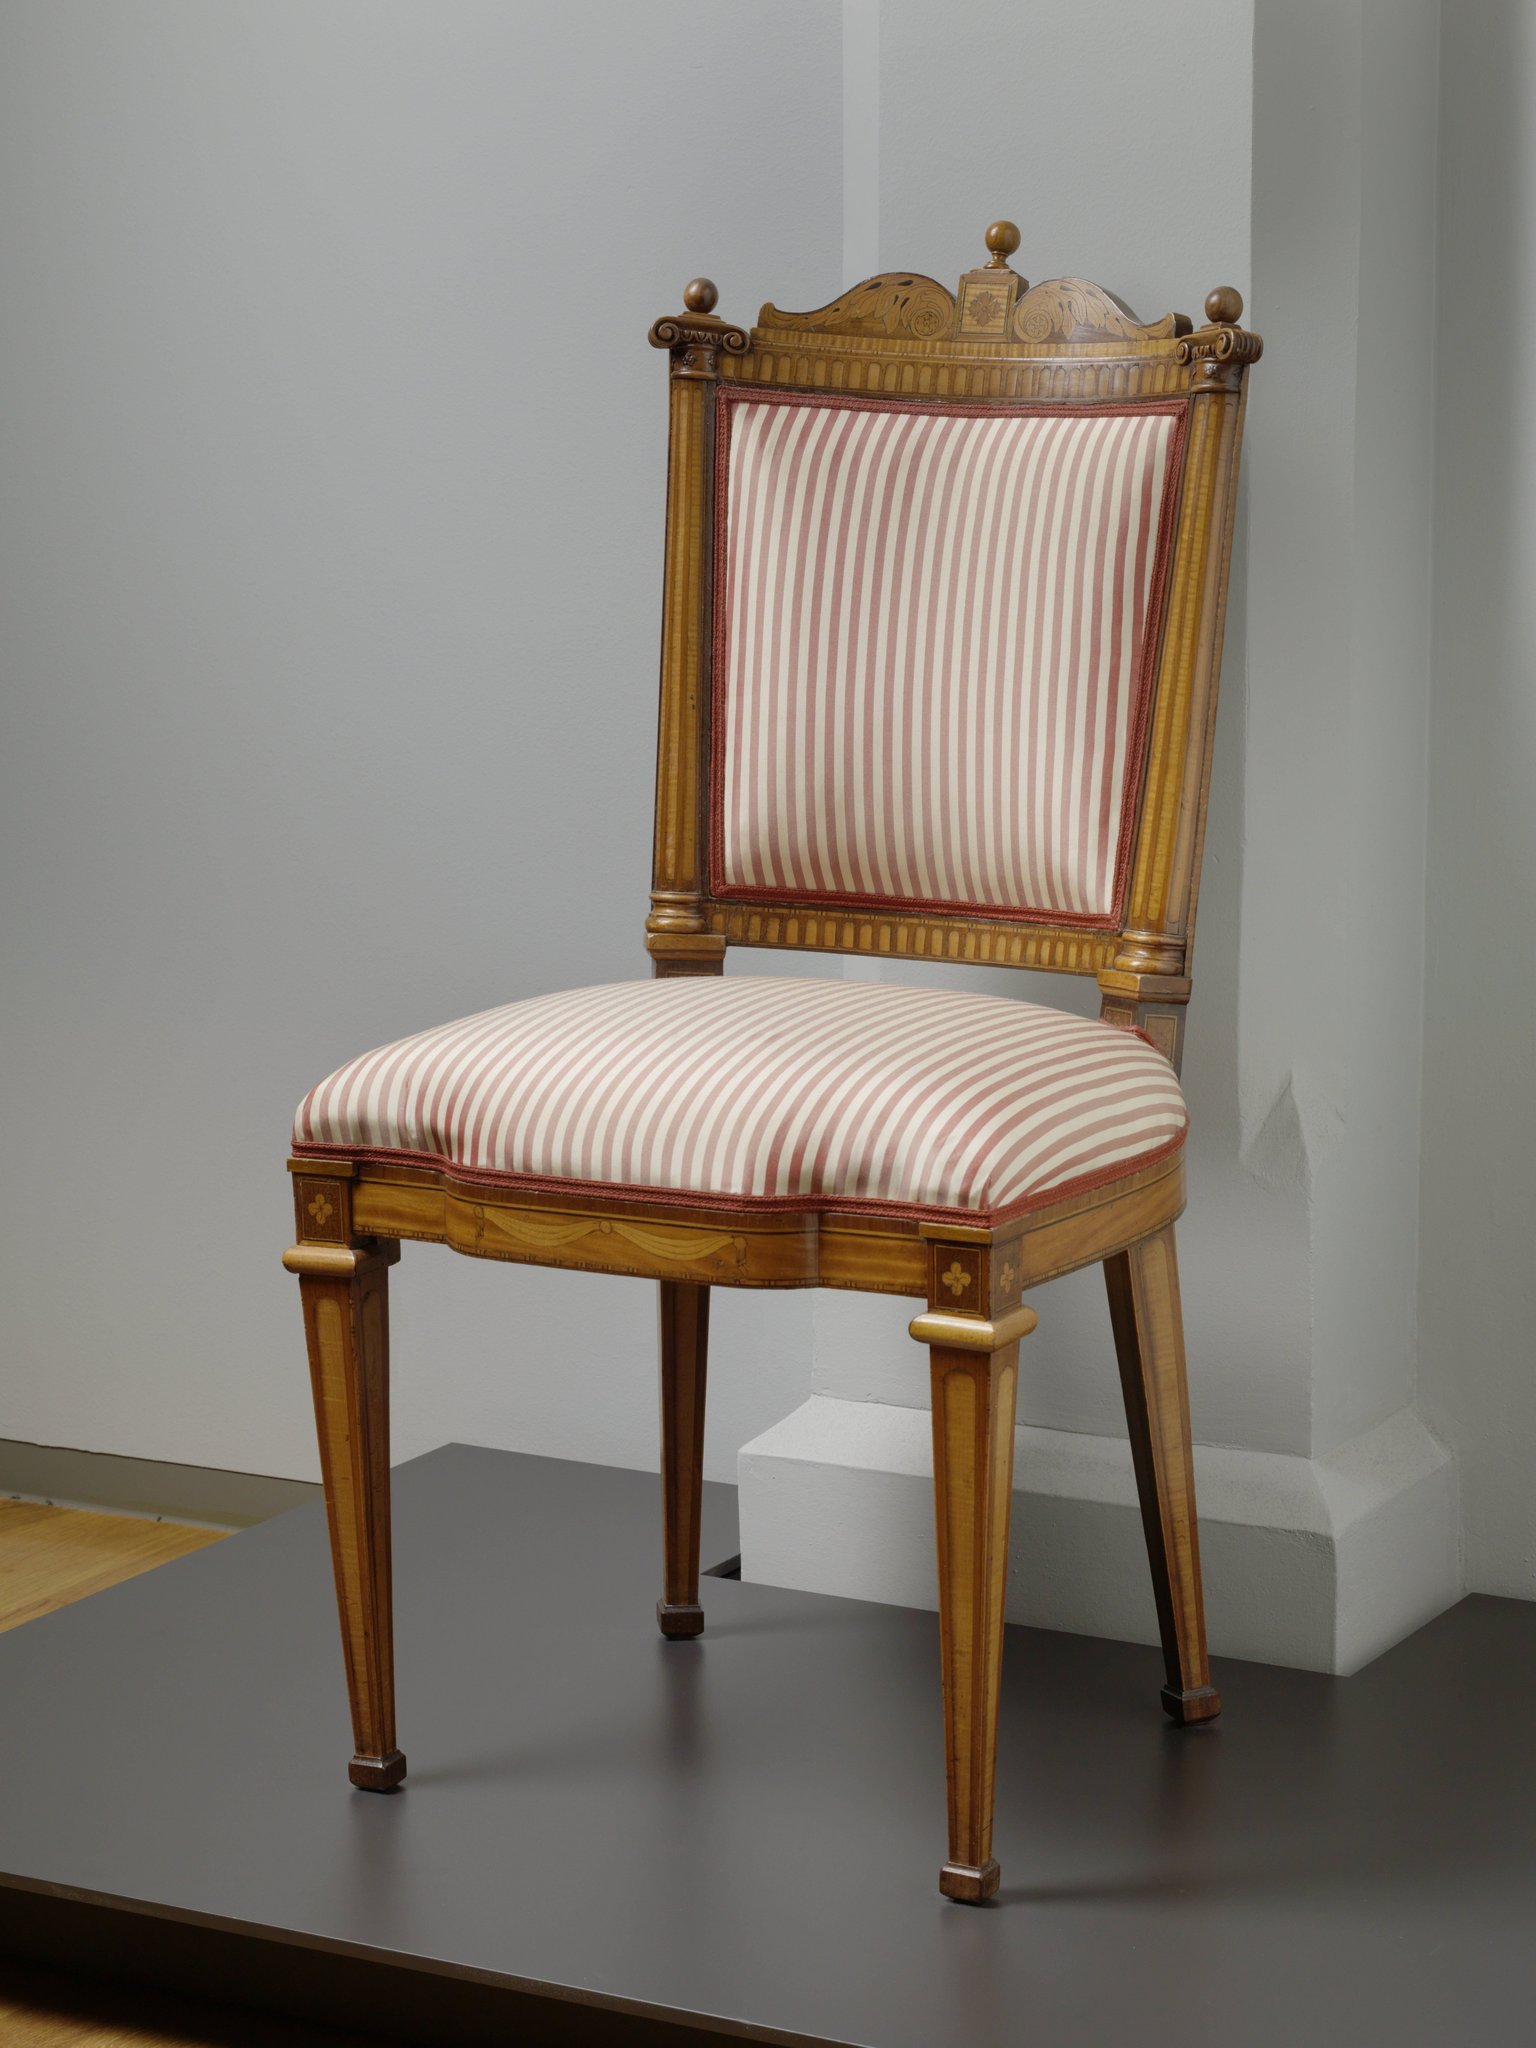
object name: furniture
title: Four chairs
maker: Anonymous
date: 1780-1790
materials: wood, textile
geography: netherlands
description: The shape of these chairs was common in the Neoclassical period in the Netherlands. At that time, it was usual for the decoration to be carved on the chair. In the case of these four chairs, however, the decoration is carried out in marquetry. This suggests that they were not made by a chairmaker, but rather by a cabinetmaker, who usually made cabinets, commodes and other such furniture.